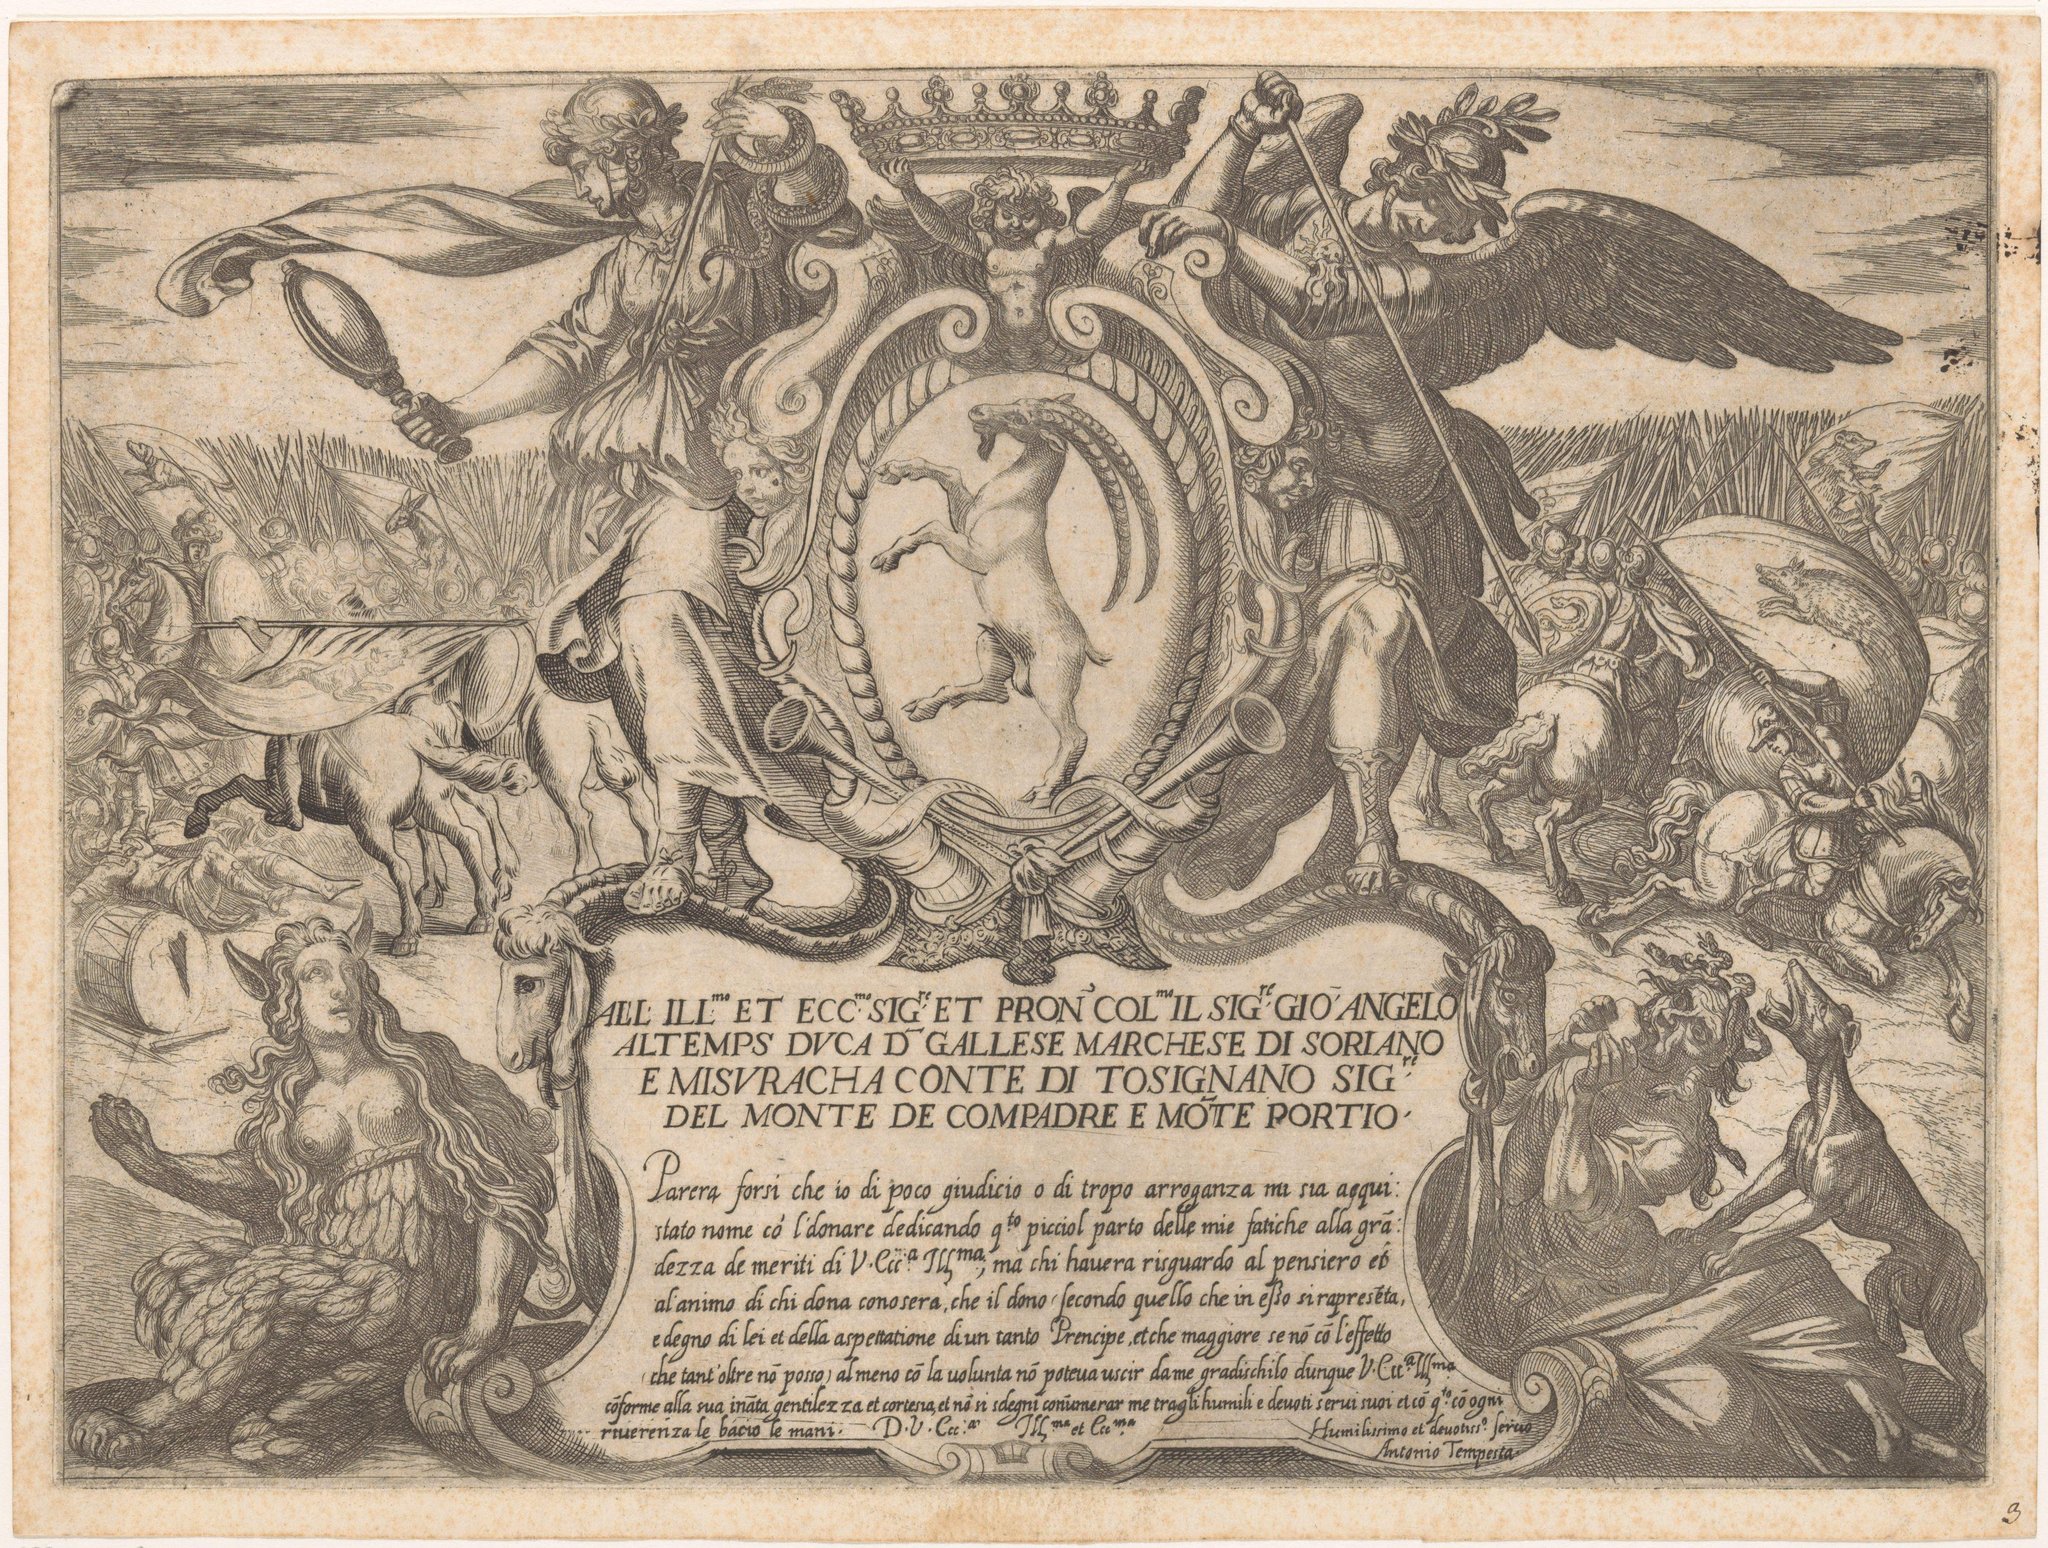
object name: titelprent, frontispice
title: Gevechtsscènes (serie 3)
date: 1601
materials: paper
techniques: etching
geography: rome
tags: coat of arms (symbol of sovereignty), envy; 'invidia' (ripa) ~ personification of one of the seven deadly sins, battle, warfare; military affairs (+ cavalry, horsemen), the soldier; the soldier's life, cheat, deceit; 'fraude', 'inganno' (ripa)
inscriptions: collector's mark: ‘Hinloopen’, collector's mark: Lugt 11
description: Titelprent met een wapenschild met een geit, geflankeerd door de personificaties van fraude en afgunst. Onder een cartouche met opdracht in het Italiaans. Op de achtergrond een strijdscène met soldaten te paard.